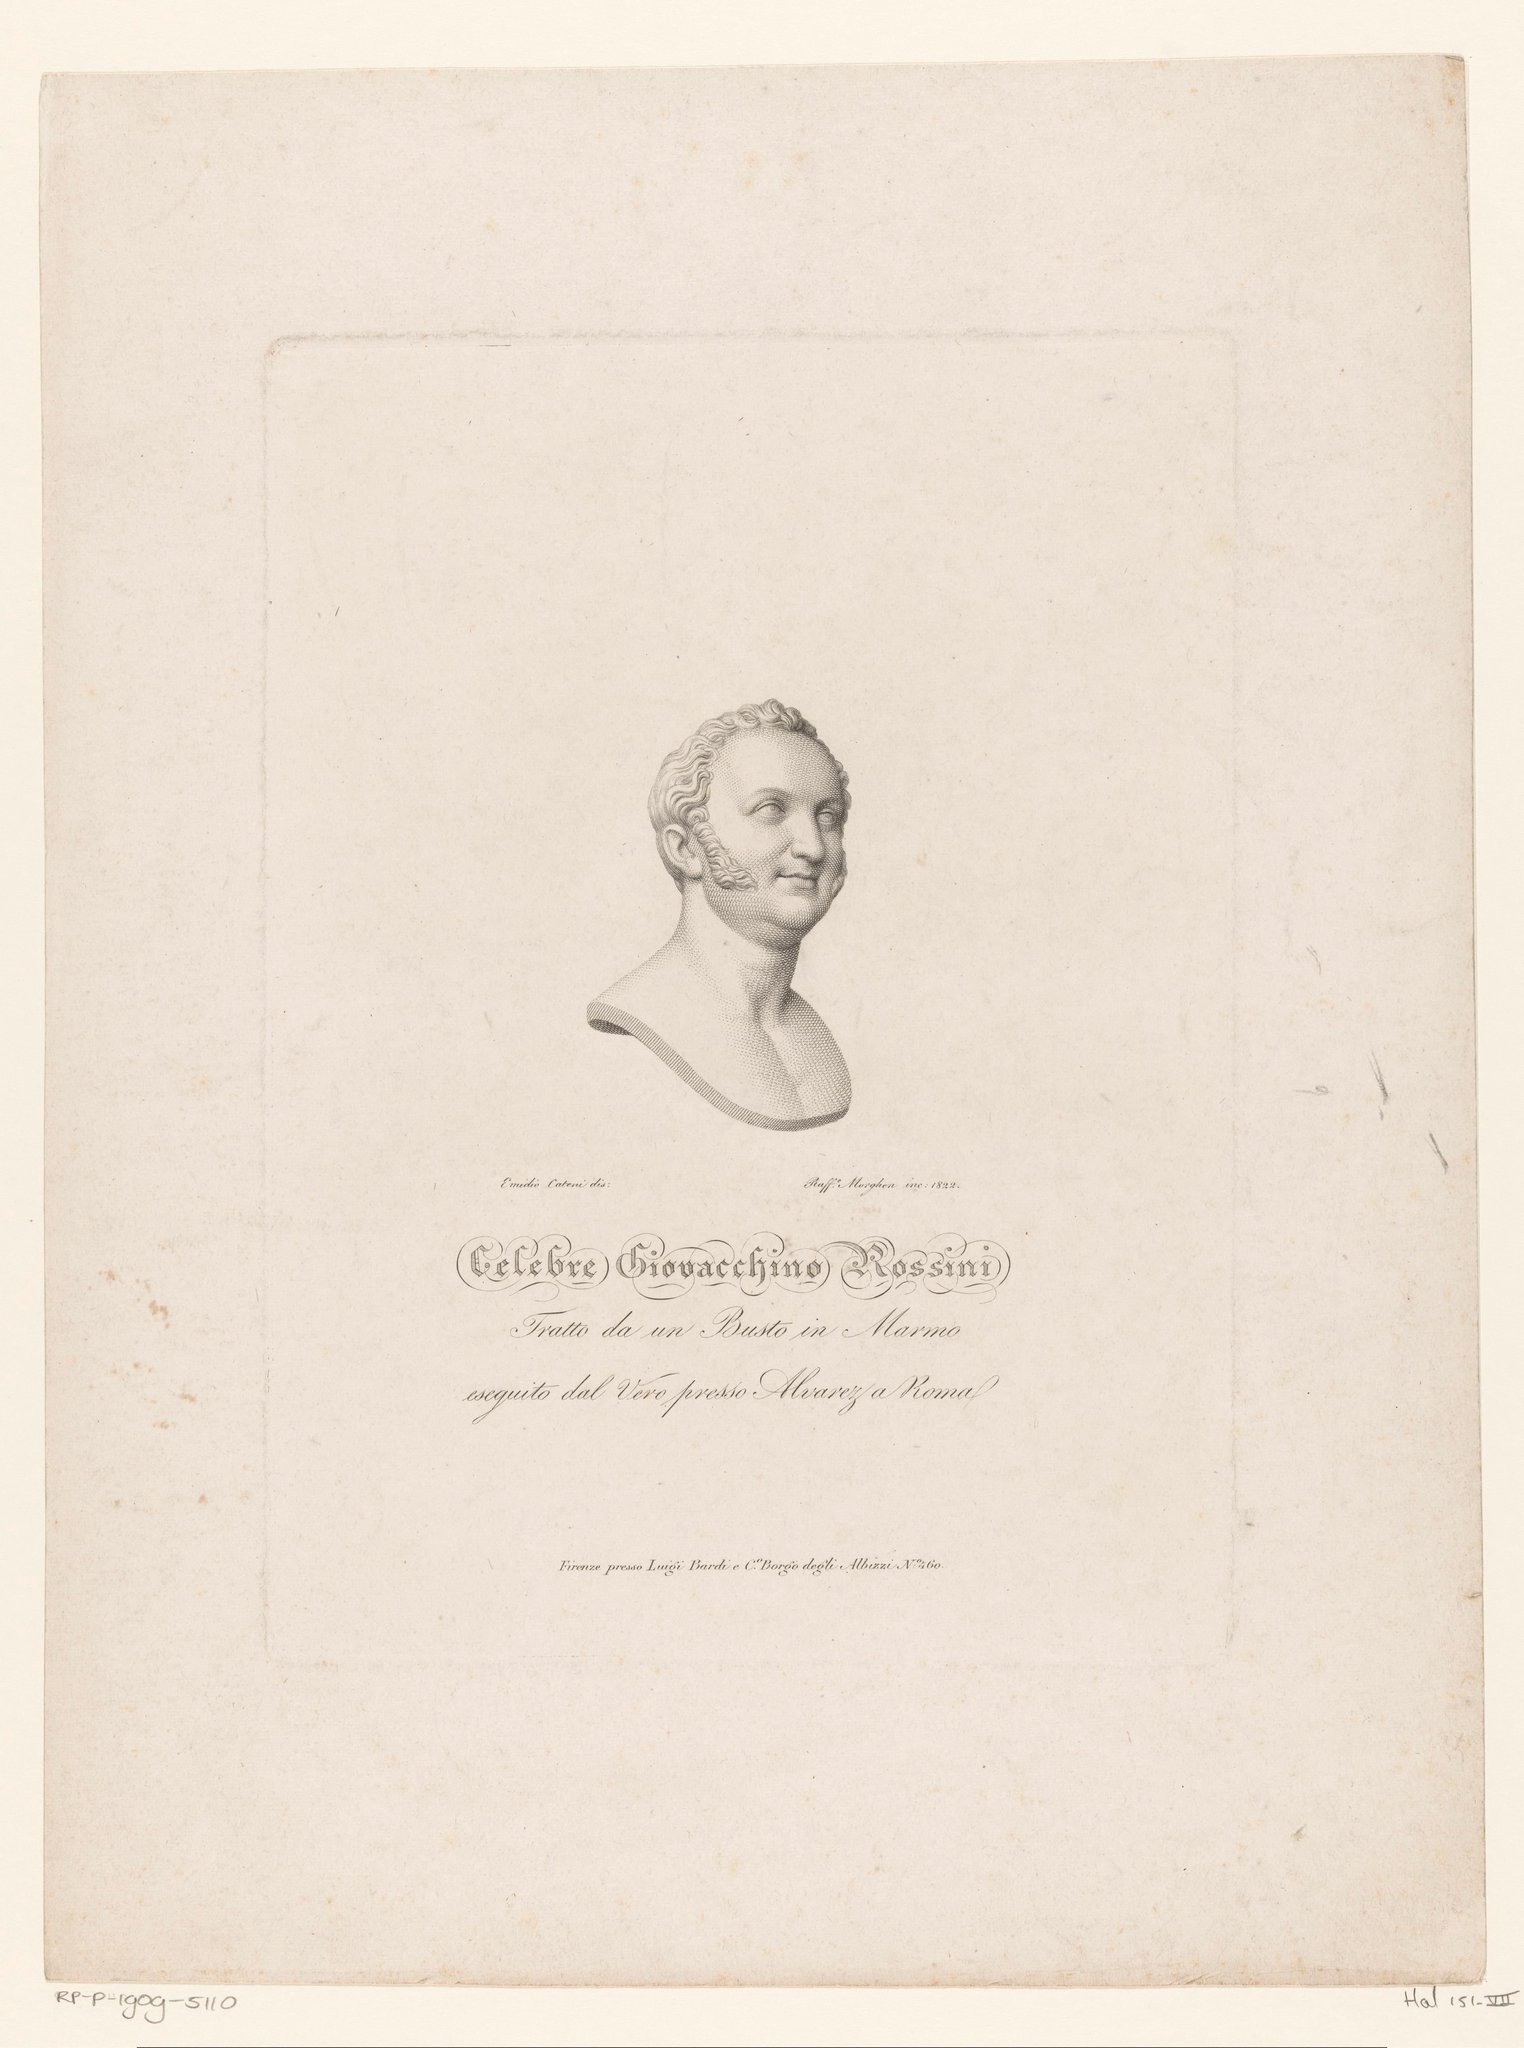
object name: print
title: Portret van componist Gioacchino Antonio Rossini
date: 1822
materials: paper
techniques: etching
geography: florence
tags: gioacchino antonio rossini, historical persons, portrait of composer, piece of sculpture, reproduction of a piece of sculpture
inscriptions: collector's mark: Lugt 2228